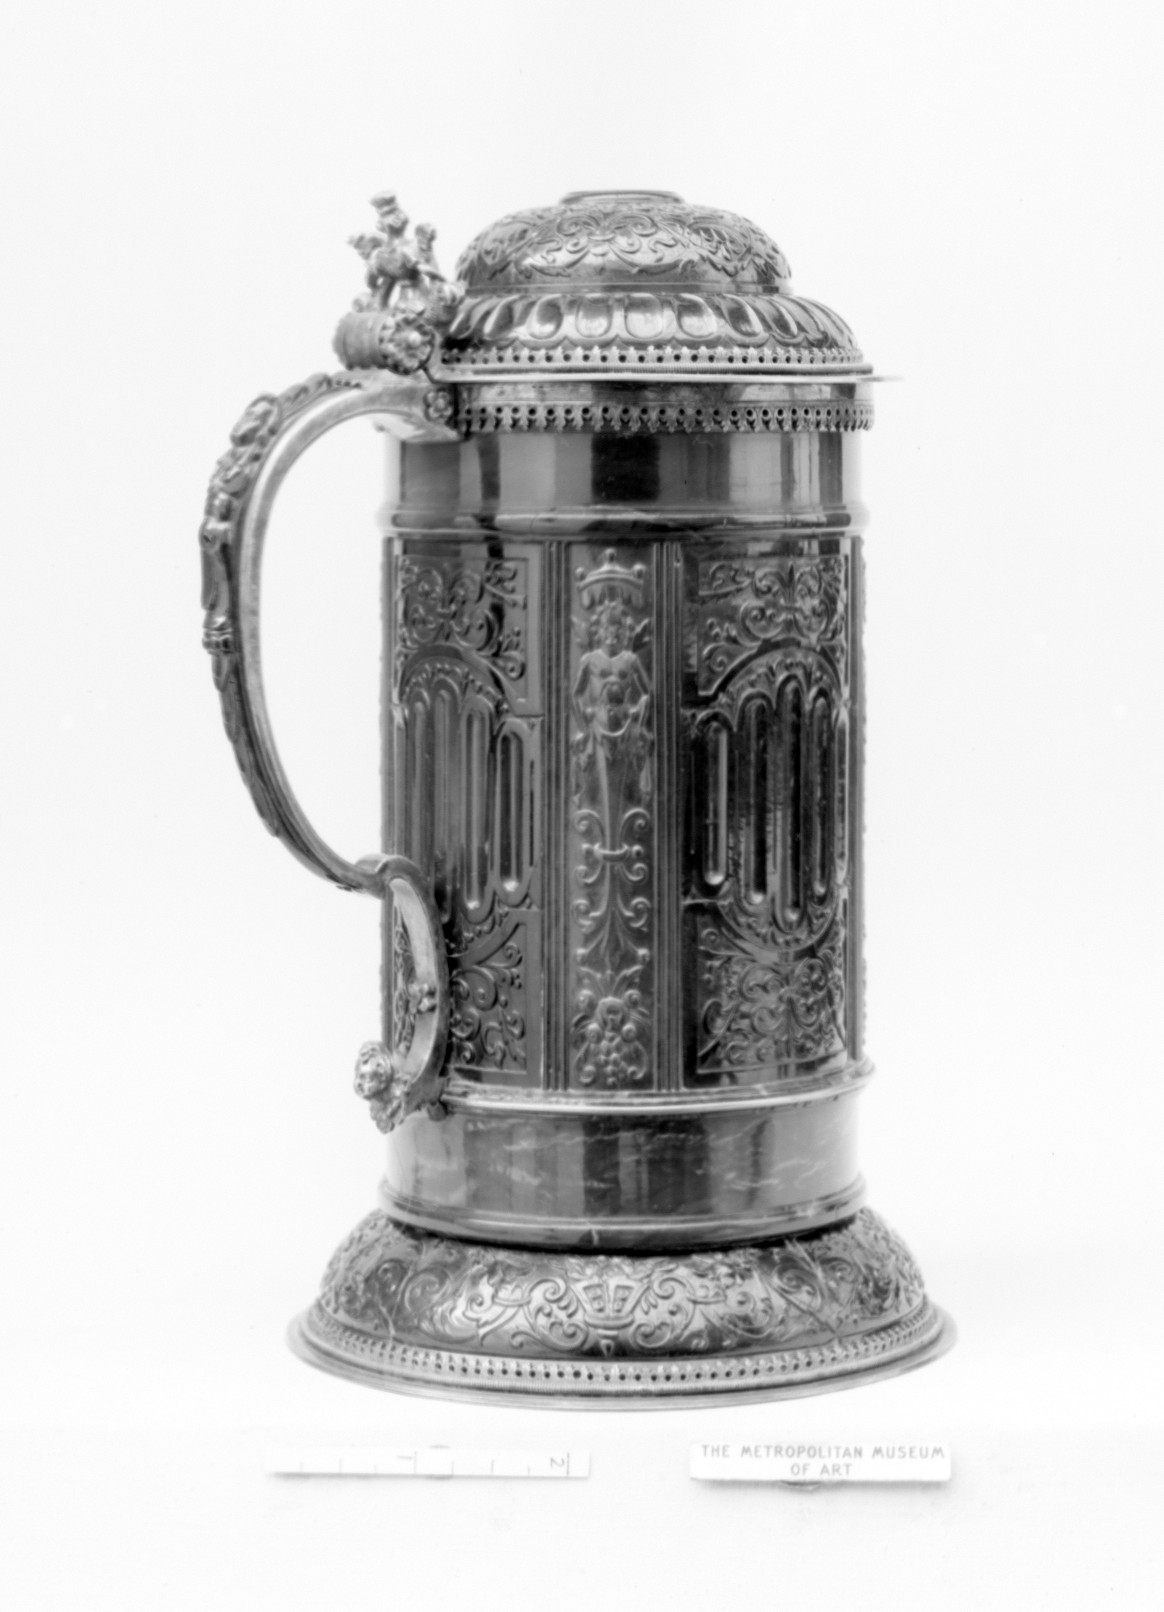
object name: tankard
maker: andreas meyer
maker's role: maker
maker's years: 1608-1647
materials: amber, silver gilt